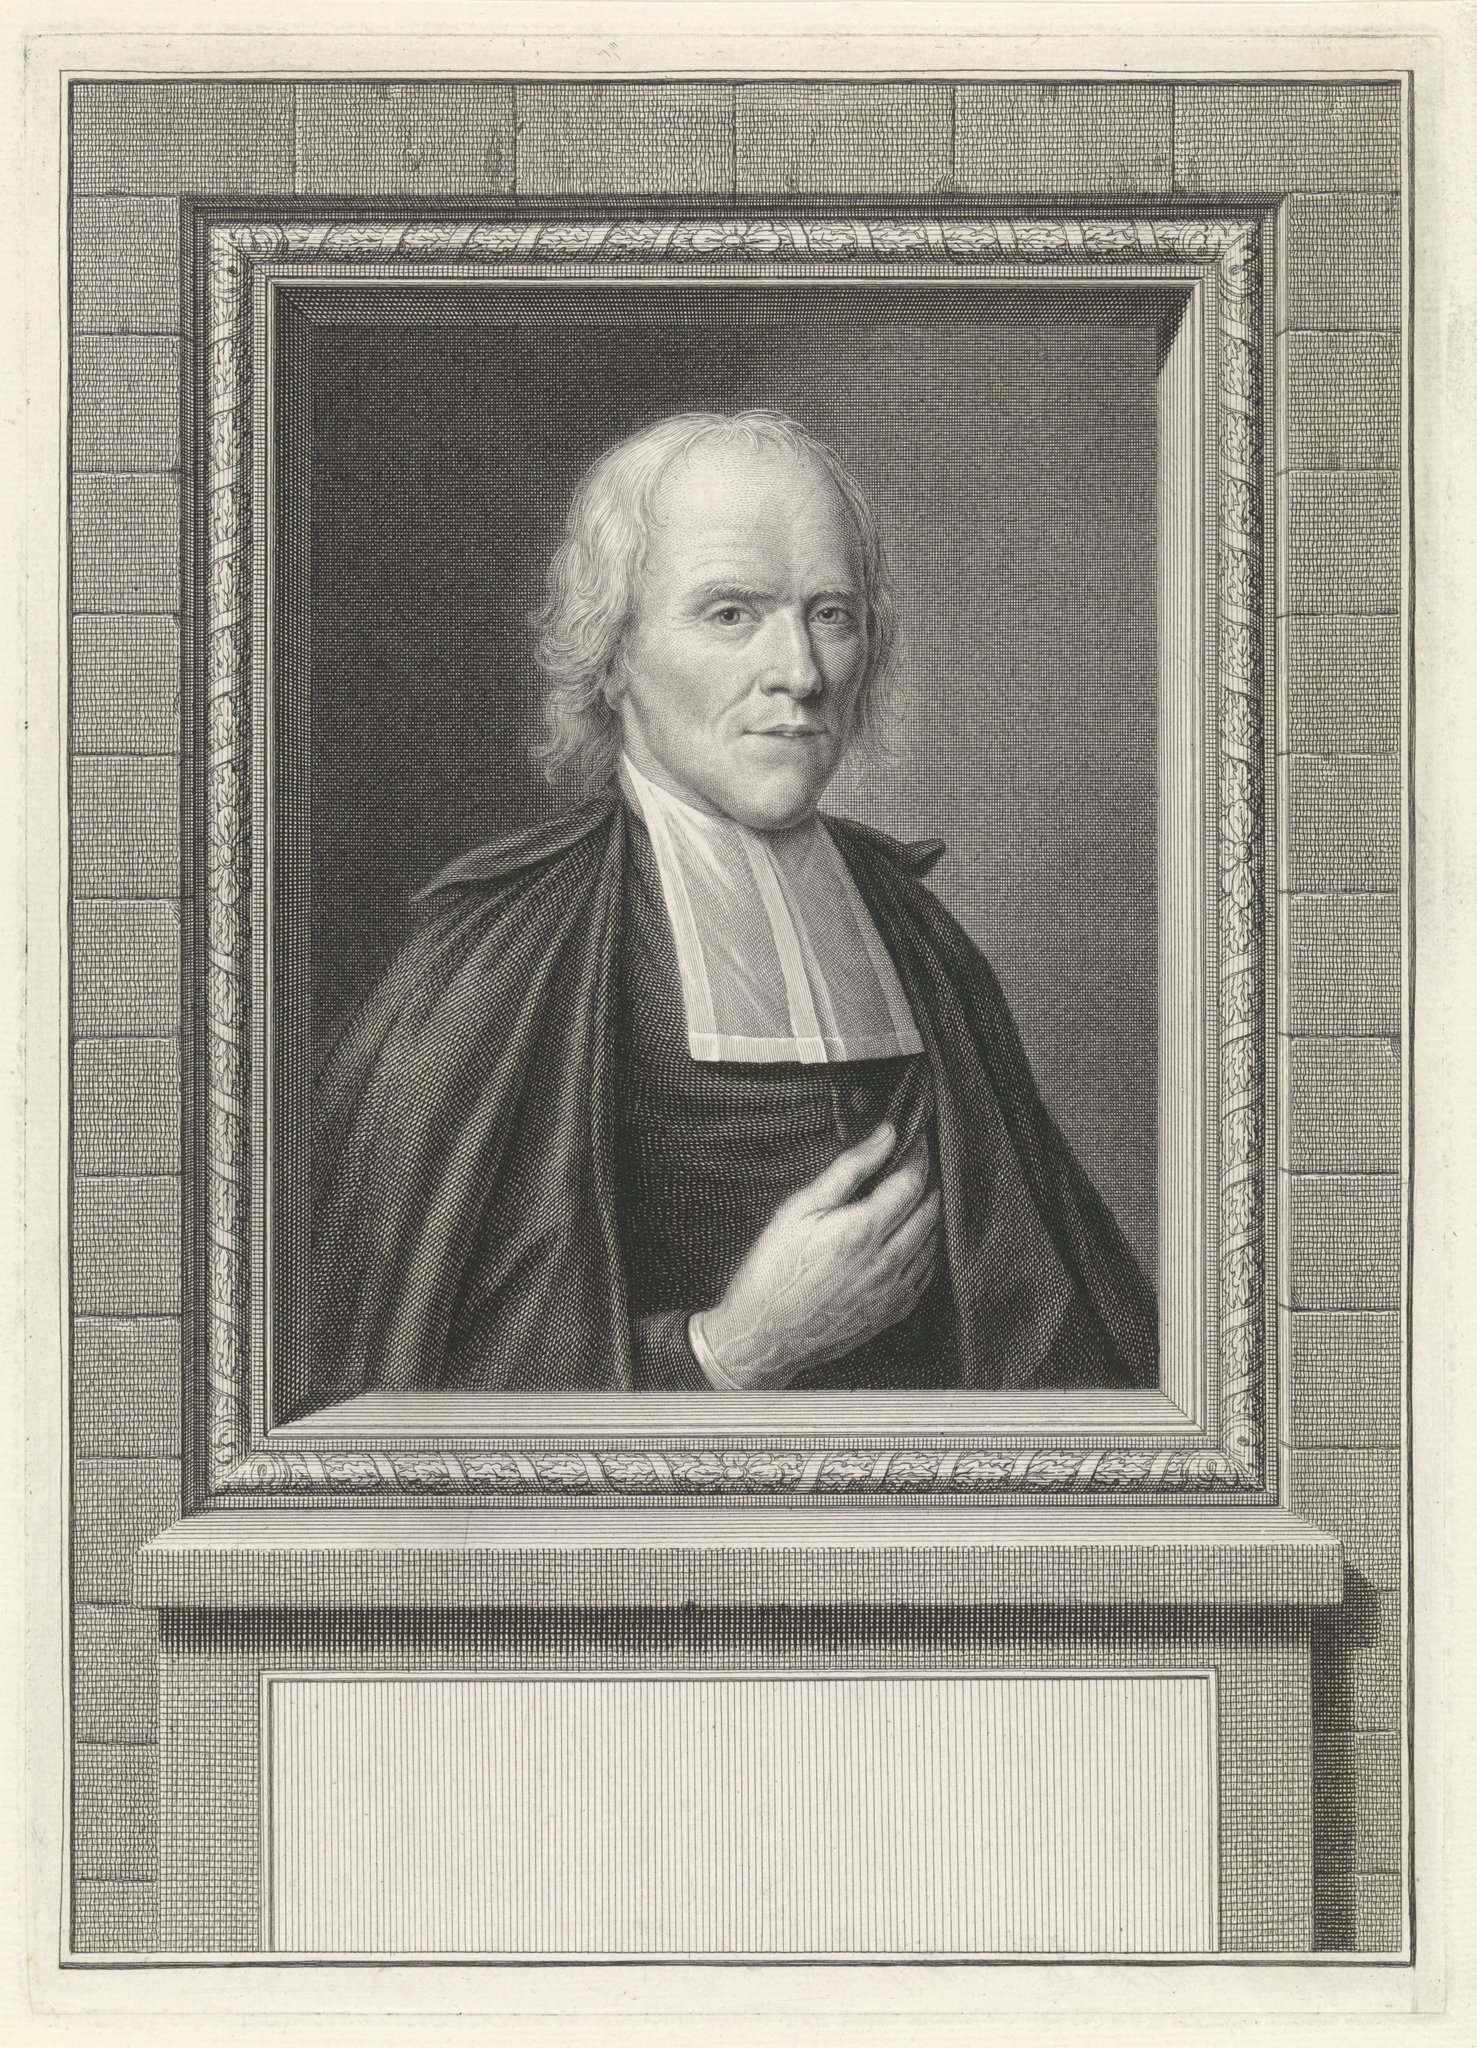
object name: print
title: Portret van Gerardus de Wind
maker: pieter tanjé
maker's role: draughtsman, print maker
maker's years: 1706-1761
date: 1753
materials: paper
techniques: engraving, etching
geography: amsterdam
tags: flushing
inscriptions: collector's mark: Lugt 240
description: Portret van Gerardus de Wind, arts en doopsgezind predikant te Middelburg.